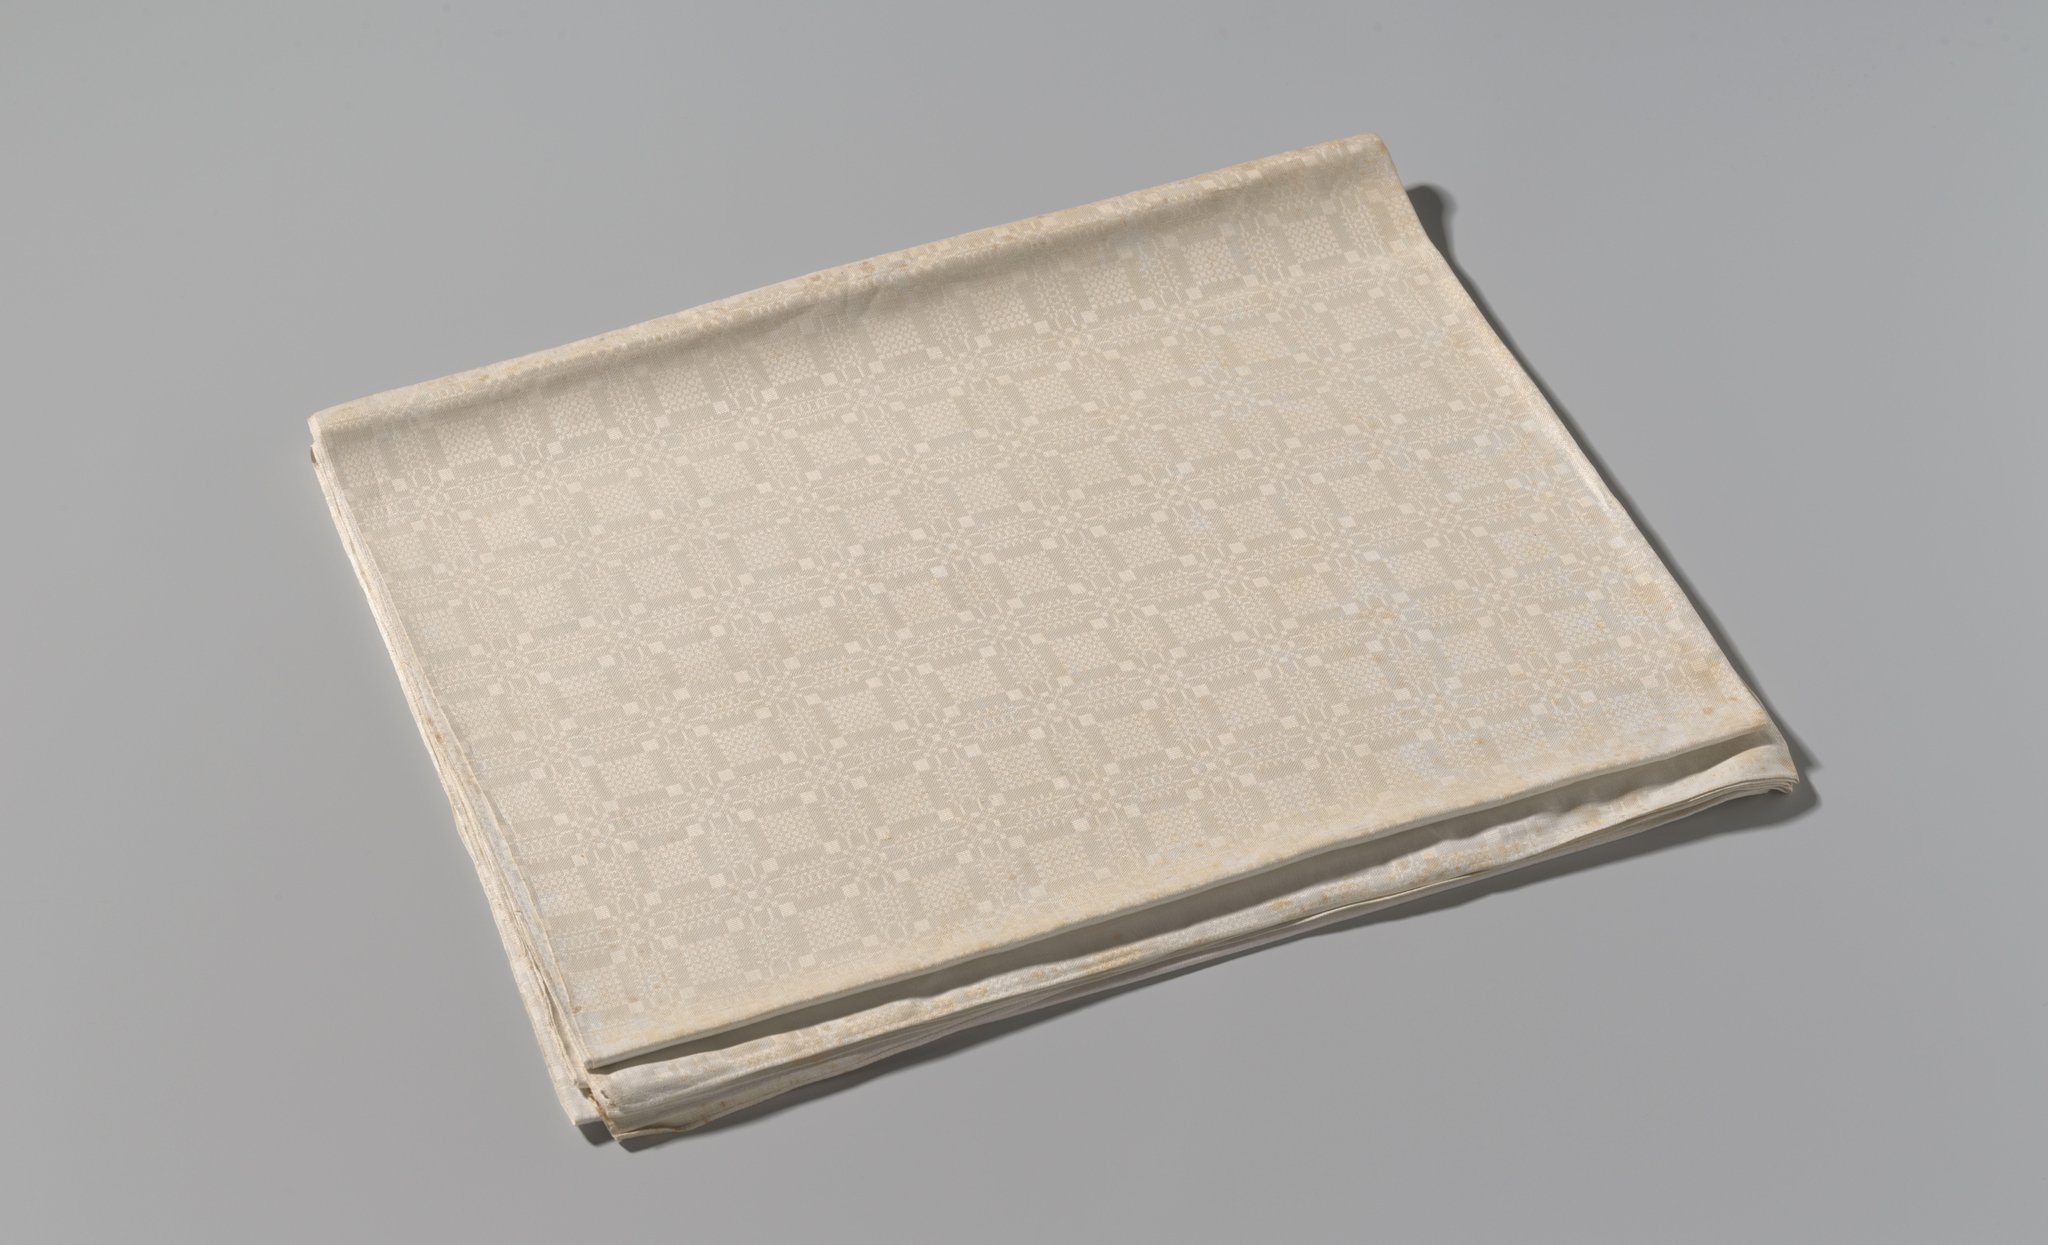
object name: tablecloth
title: Tafellaken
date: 1648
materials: linen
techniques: twill, peeled fabric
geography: netherlands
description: Wit linnen tafellaken met een pellenpatroon in keper.